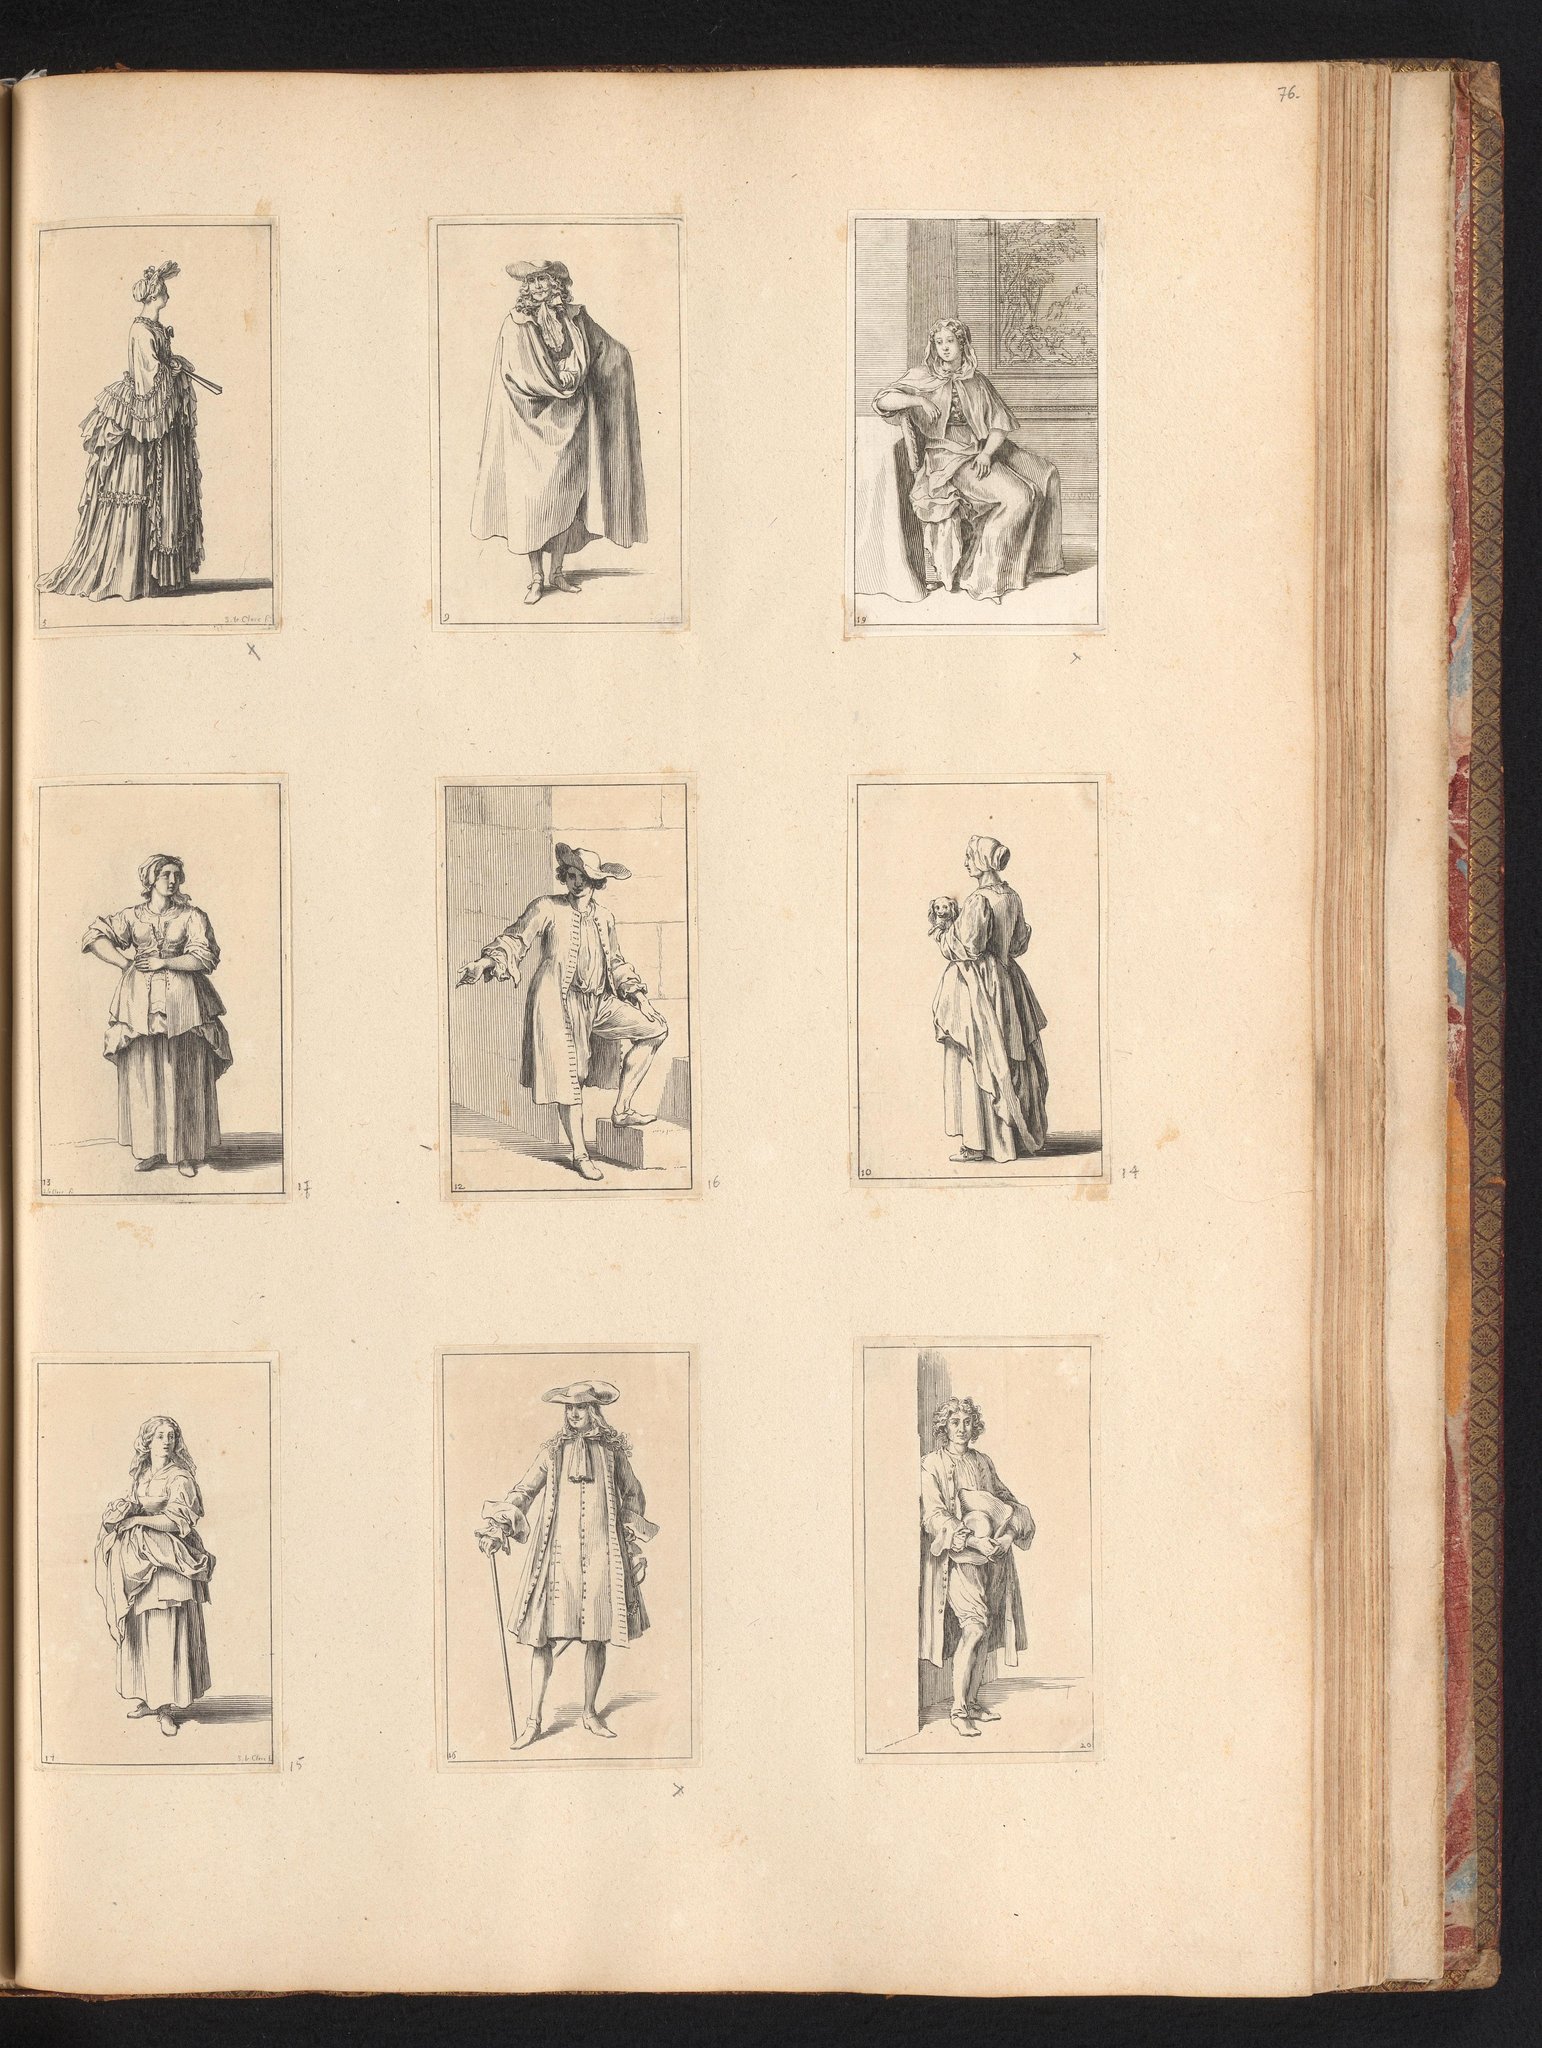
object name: album leaf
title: Les Figures à la mode dédiées à M. le Duc de Bourgogne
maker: sébastien leclerc (i)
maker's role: print maker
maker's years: 1637-1714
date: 1685-1698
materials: paper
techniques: etching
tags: folk costume, regional costume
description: Deze prenten maken deel uit van een serie met 21 prenten van verschillende personen in bijbehorende kostuums.